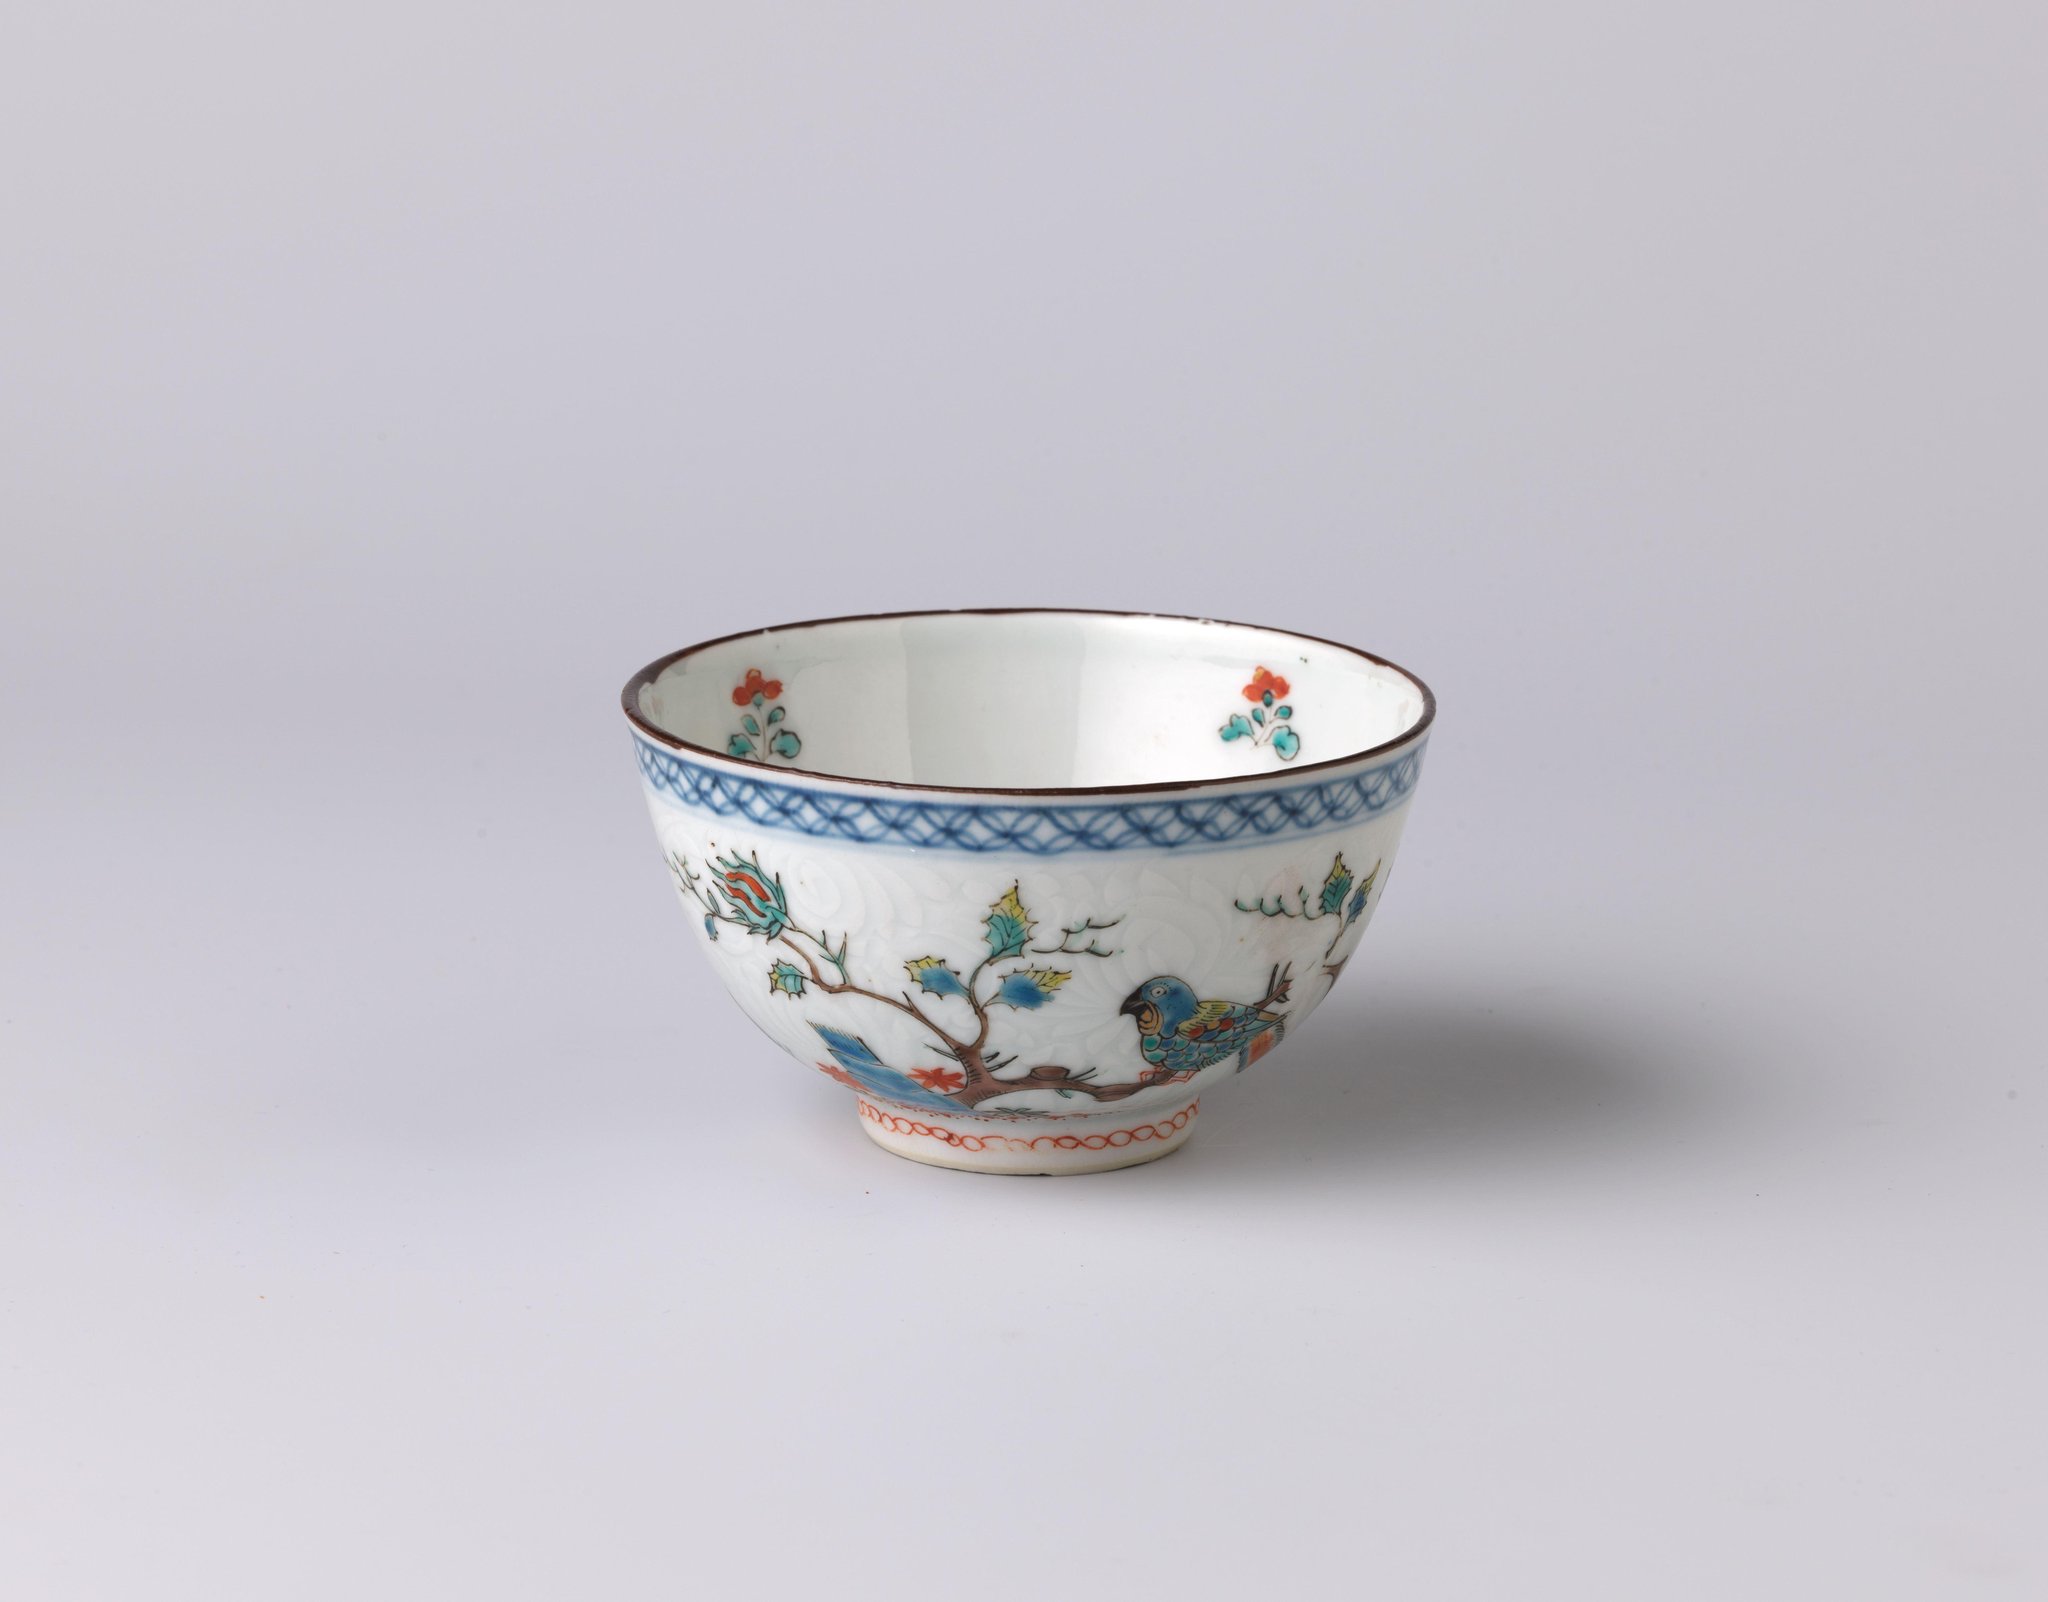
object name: bowl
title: Bowl with insiced floral scrolls and a tree with parrots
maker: Anonymous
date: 1700-1749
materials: cobalt, glaze, paint, porcelain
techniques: firing, turning, vitrification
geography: china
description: Kop van porselein. Veelkleurig beschilderd met vogels in bloeiende struiken.